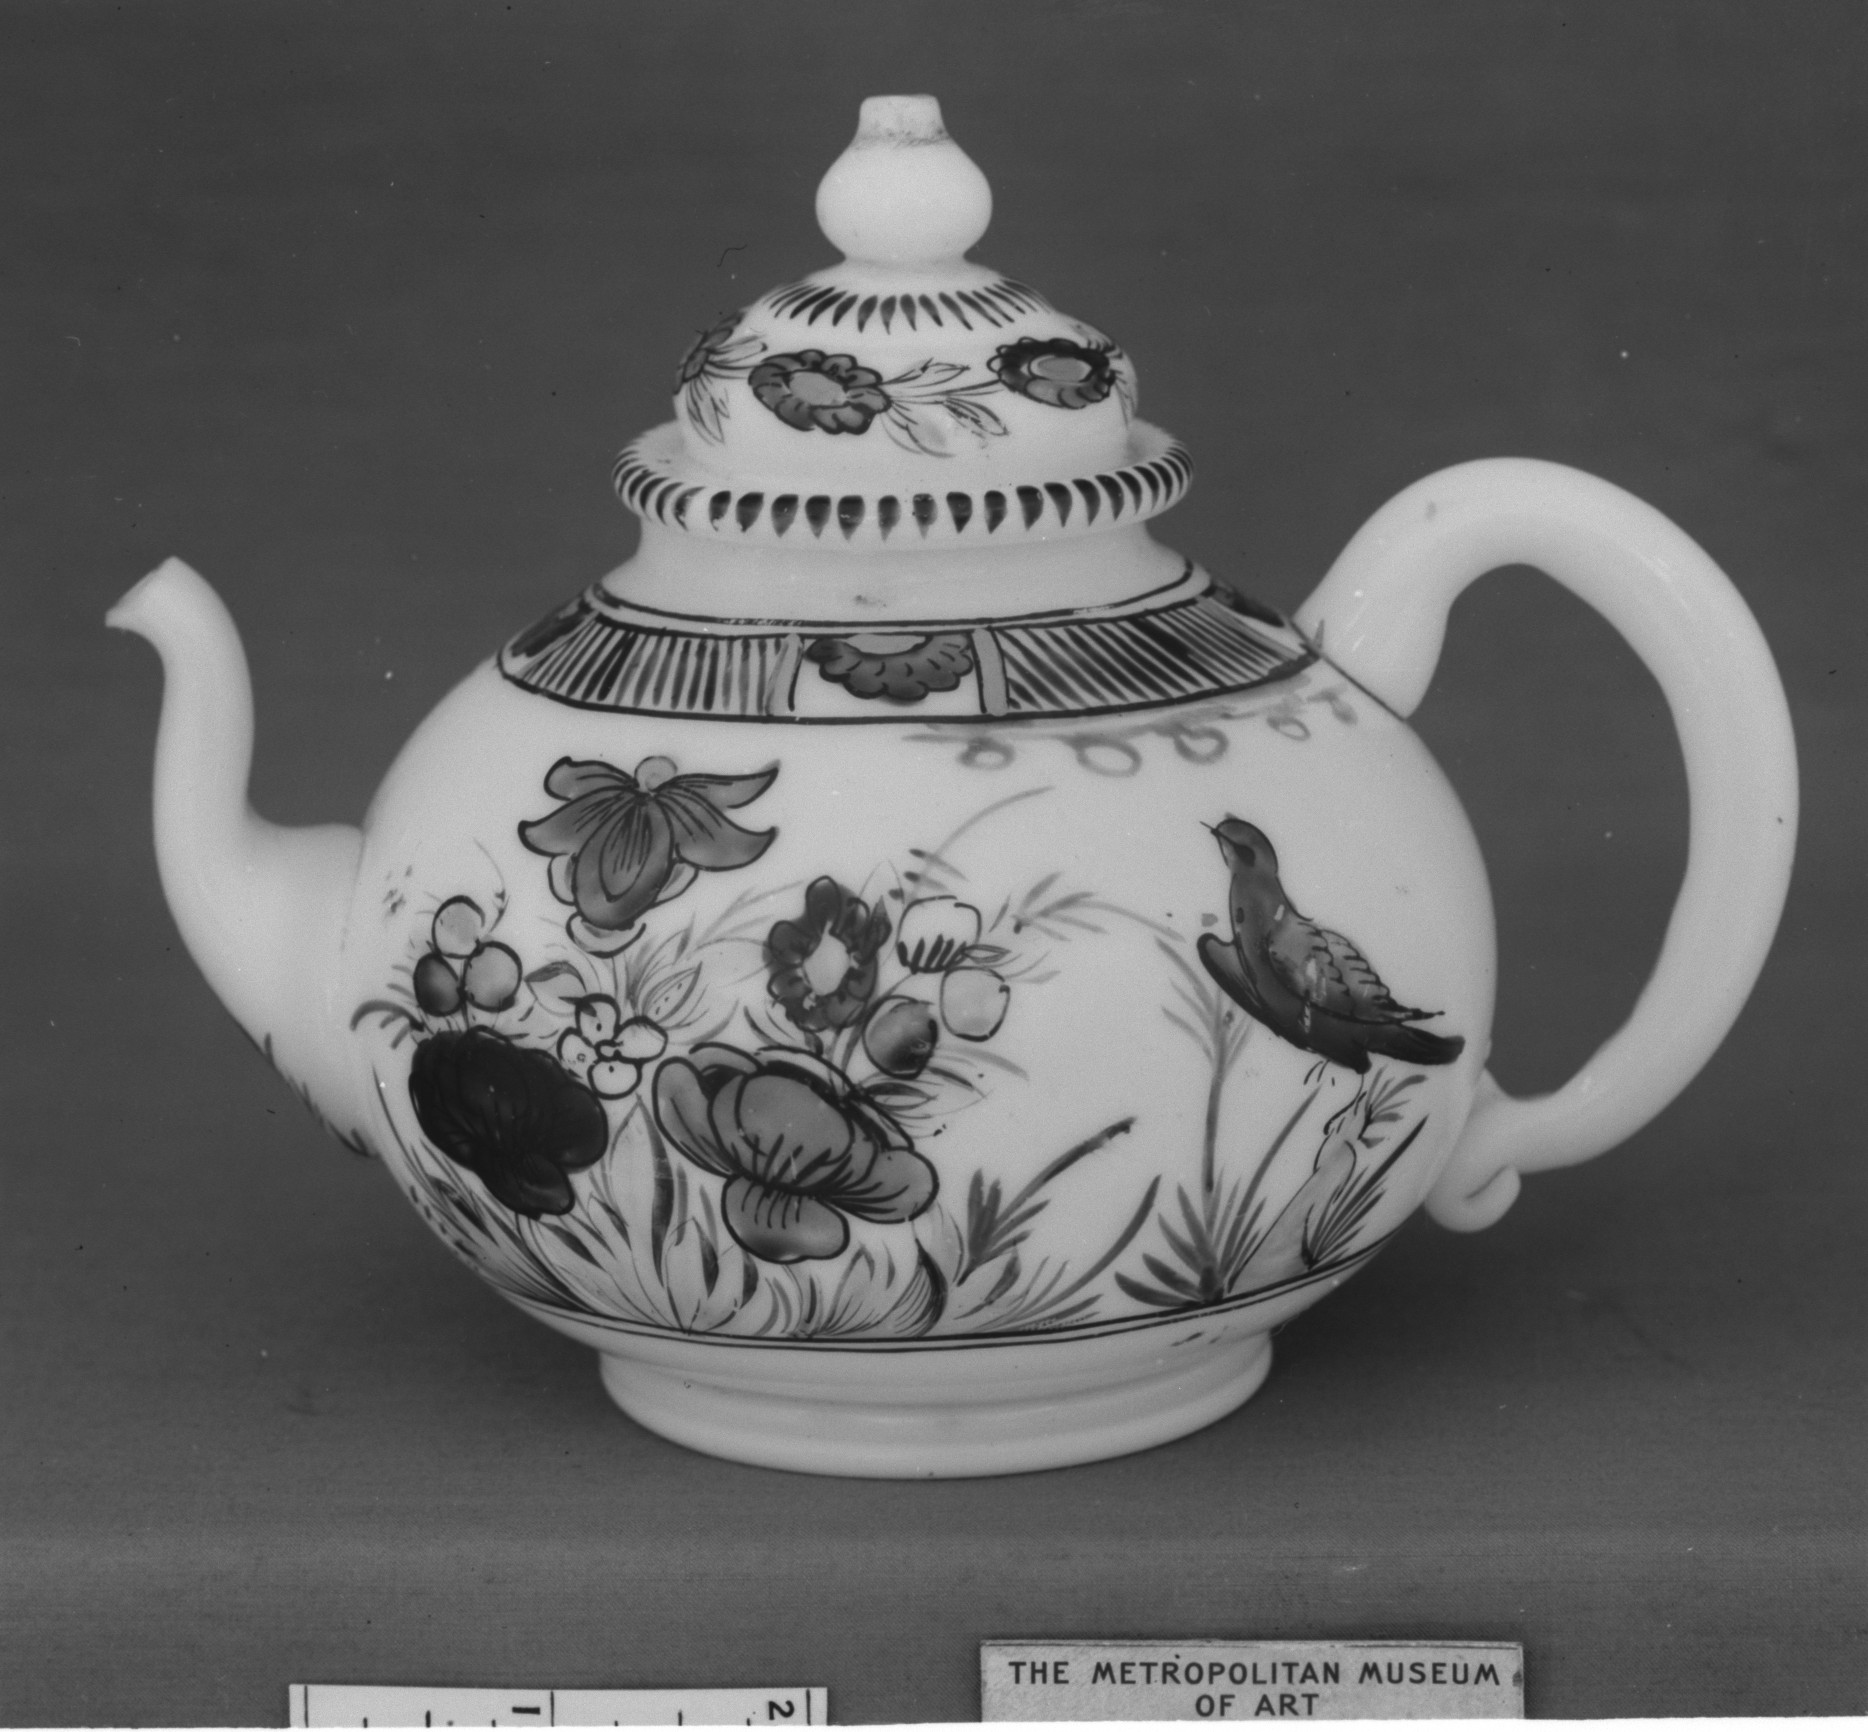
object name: teapot with cover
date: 1750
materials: glass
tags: birds,flowers